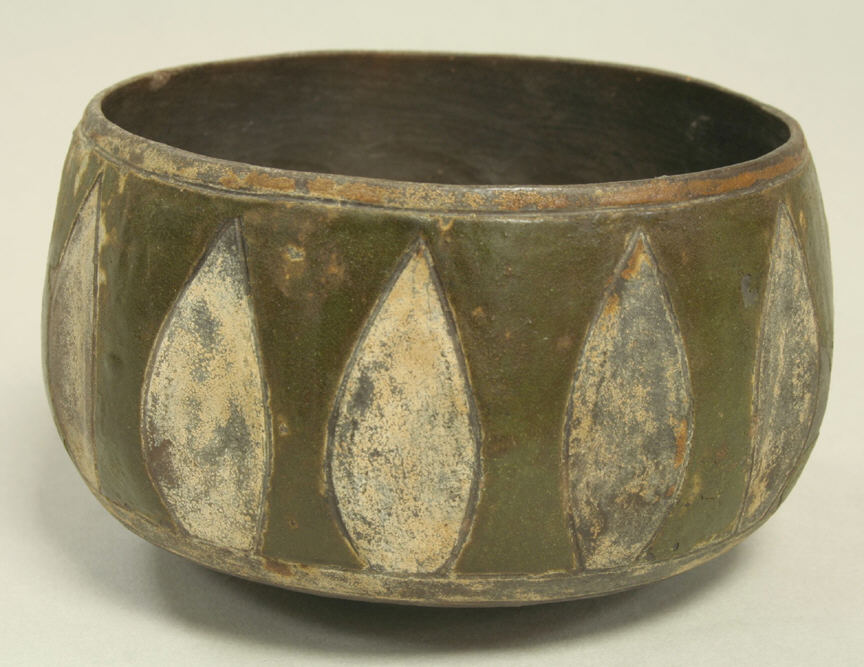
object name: bowl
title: Greyware Bowl with Incised Designs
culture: paracas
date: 300-201 BCE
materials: ceramic, pigment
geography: peru